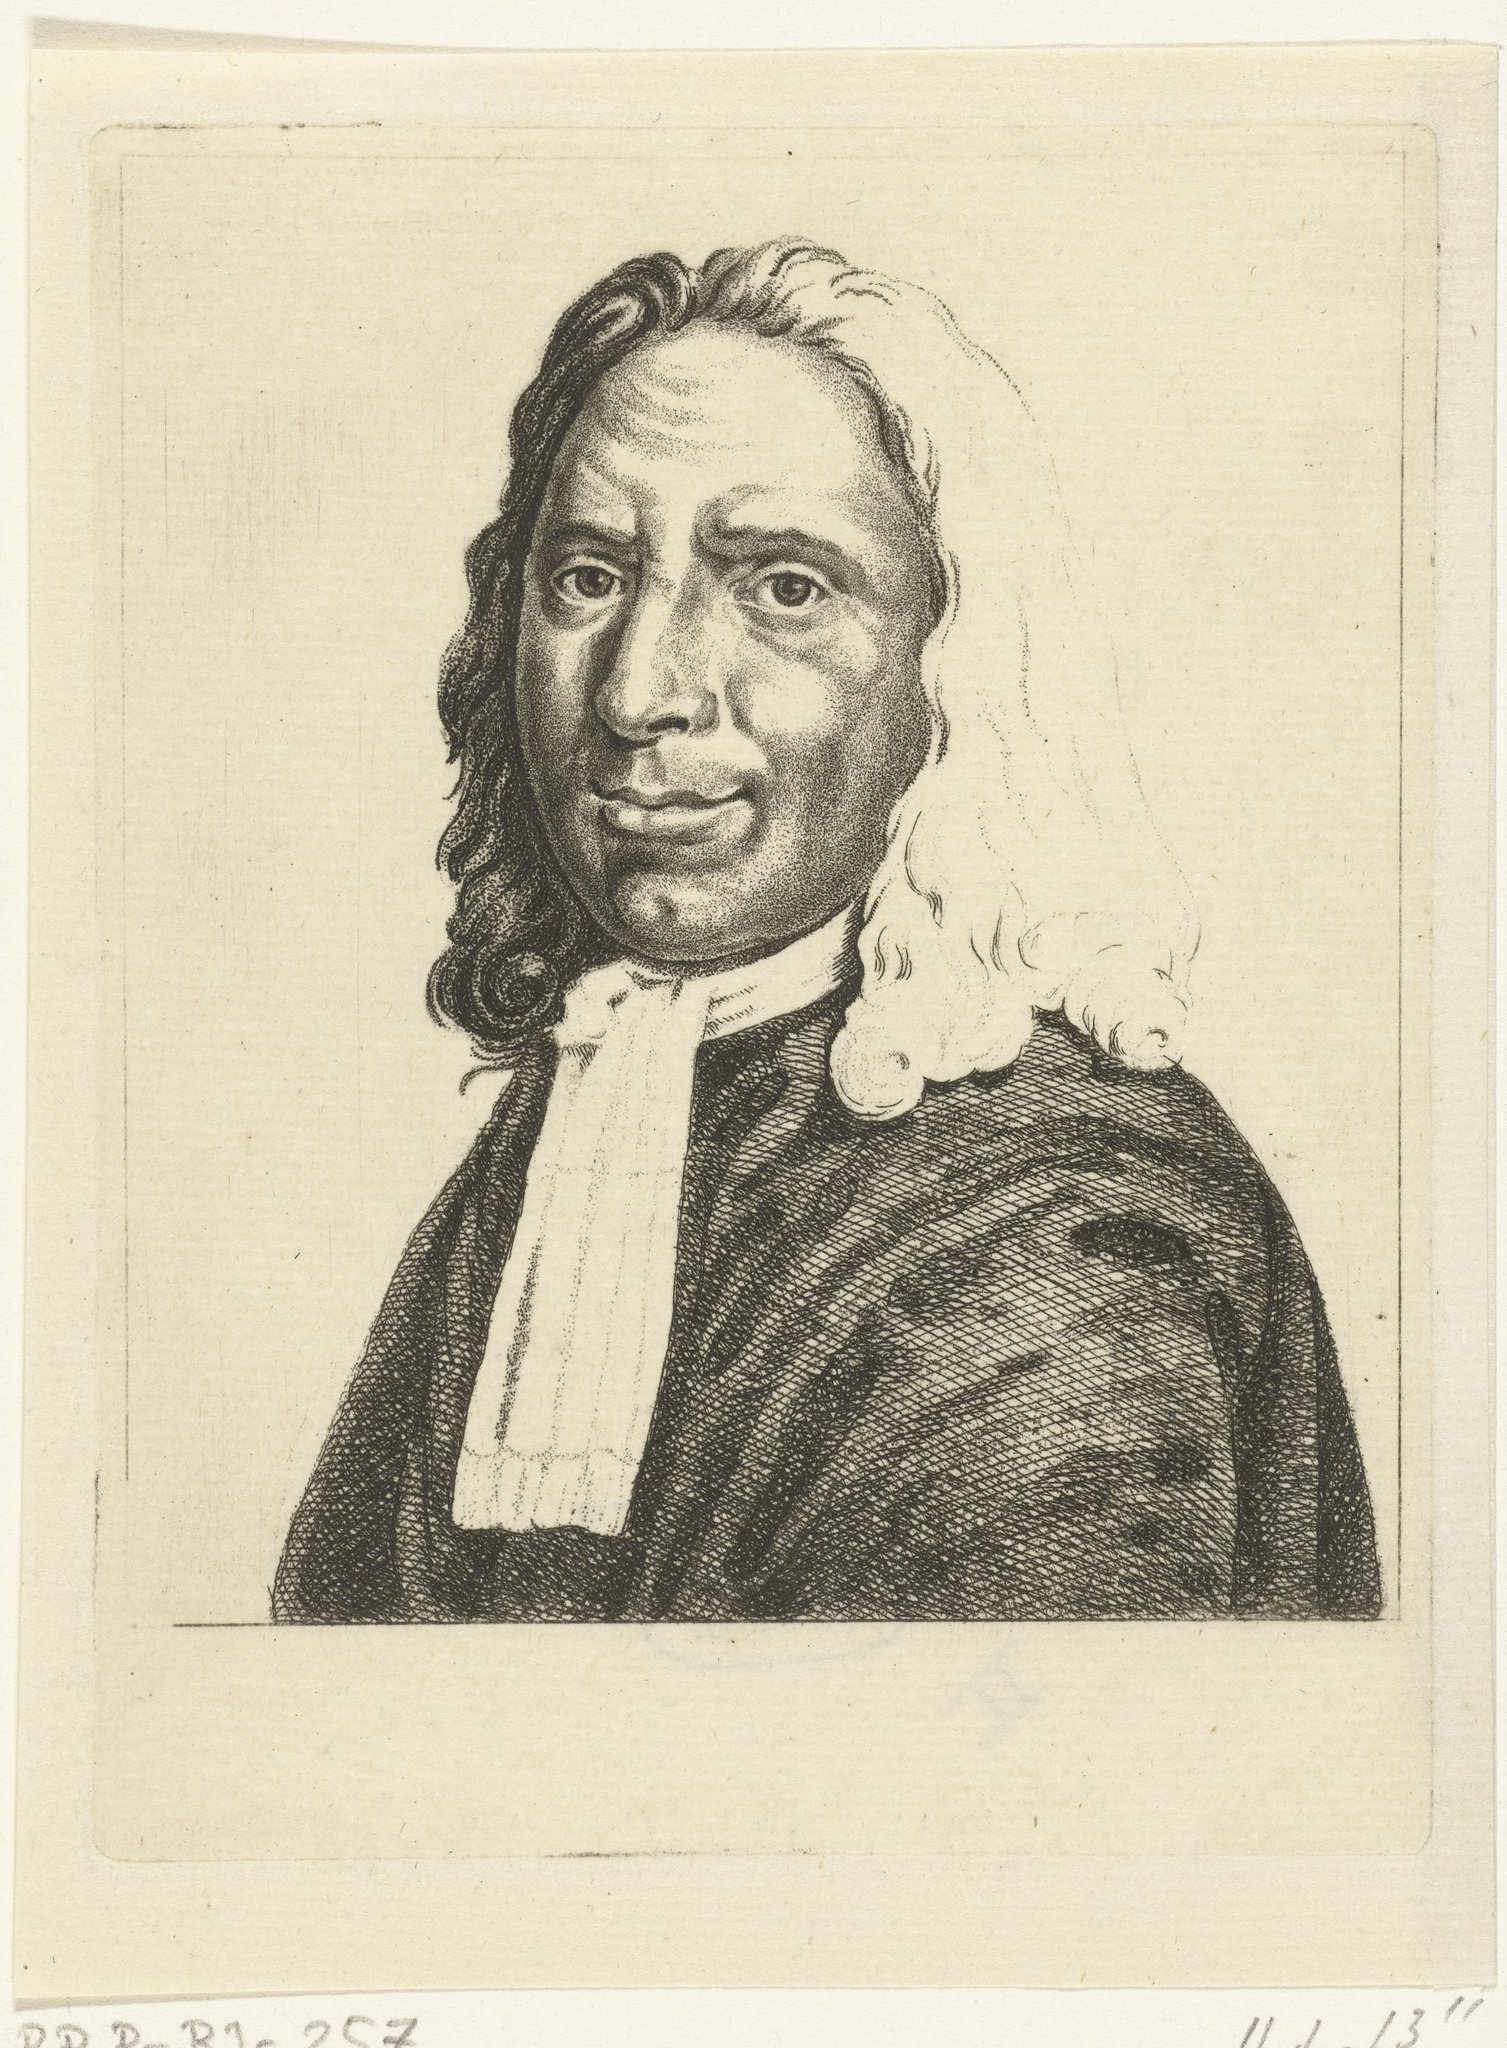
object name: print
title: Portret van Albert Cuyp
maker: ernst willem jan bagelaar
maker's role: draughtsman, print maker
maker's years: 1775-1837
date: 1798-1837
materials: paper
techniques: etching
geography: netherlands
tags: haarlem, richard brakenburg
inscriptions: collector's mark: Lugt 2228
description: Volgens H&L portret van A. Cuyp, echter wellicht portret van de schilder R. Brakenburg